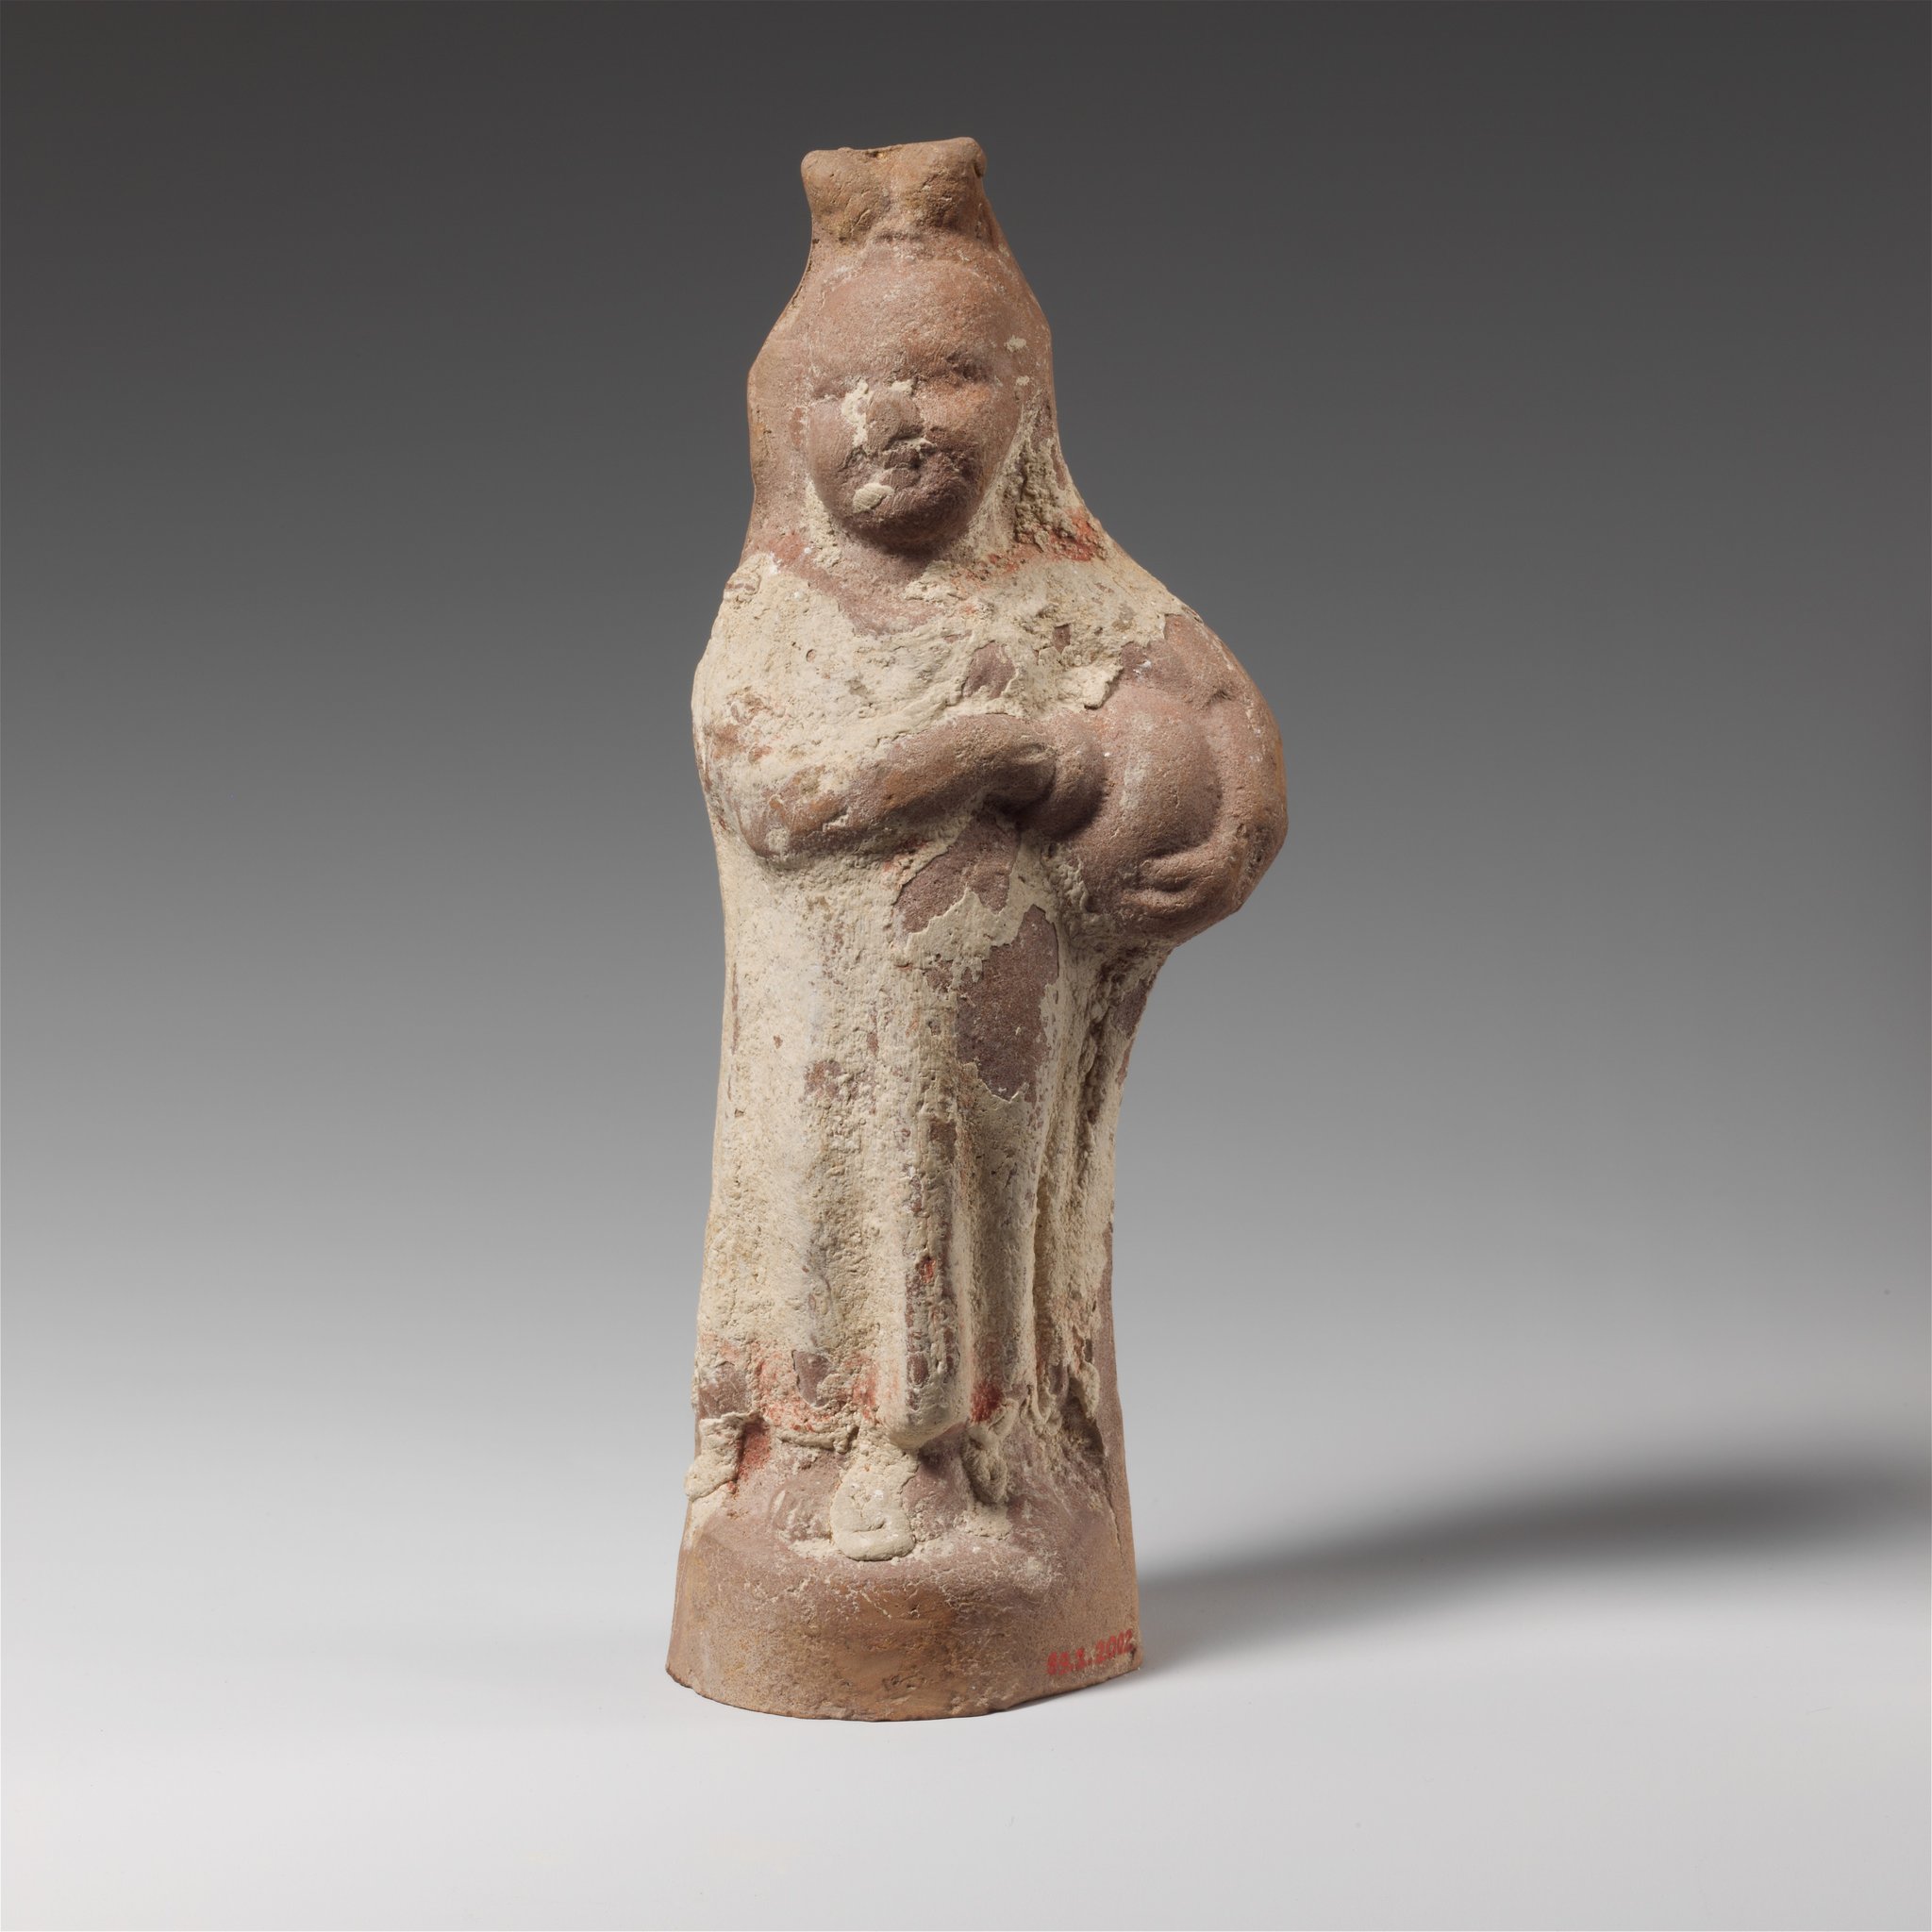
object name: statuette, harpokrates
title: Terracotta statuette of Harpocrates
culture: roman, egyptian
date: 101-200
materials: terracotta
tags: harpokrates